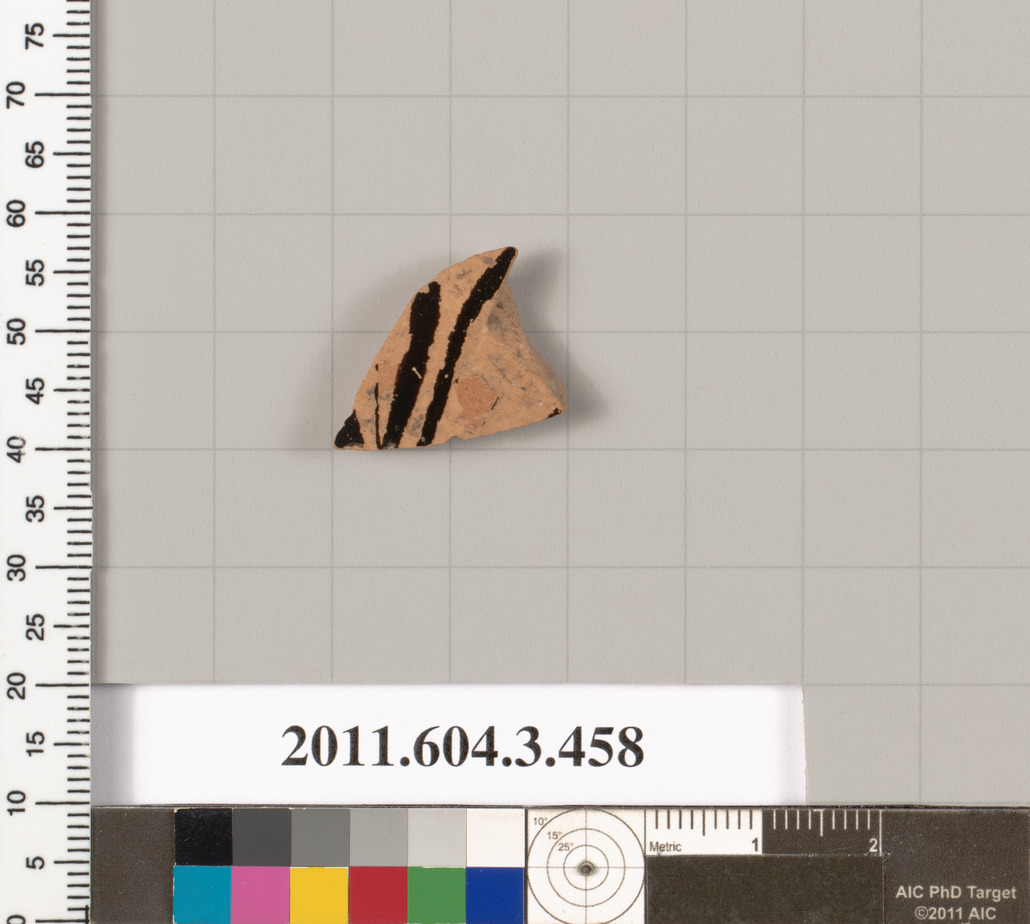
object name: neck amphora fragment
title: Terracotta fragment of a neck-amphora (jar)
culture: greek, attic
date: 490-480 BCE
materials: terracotta